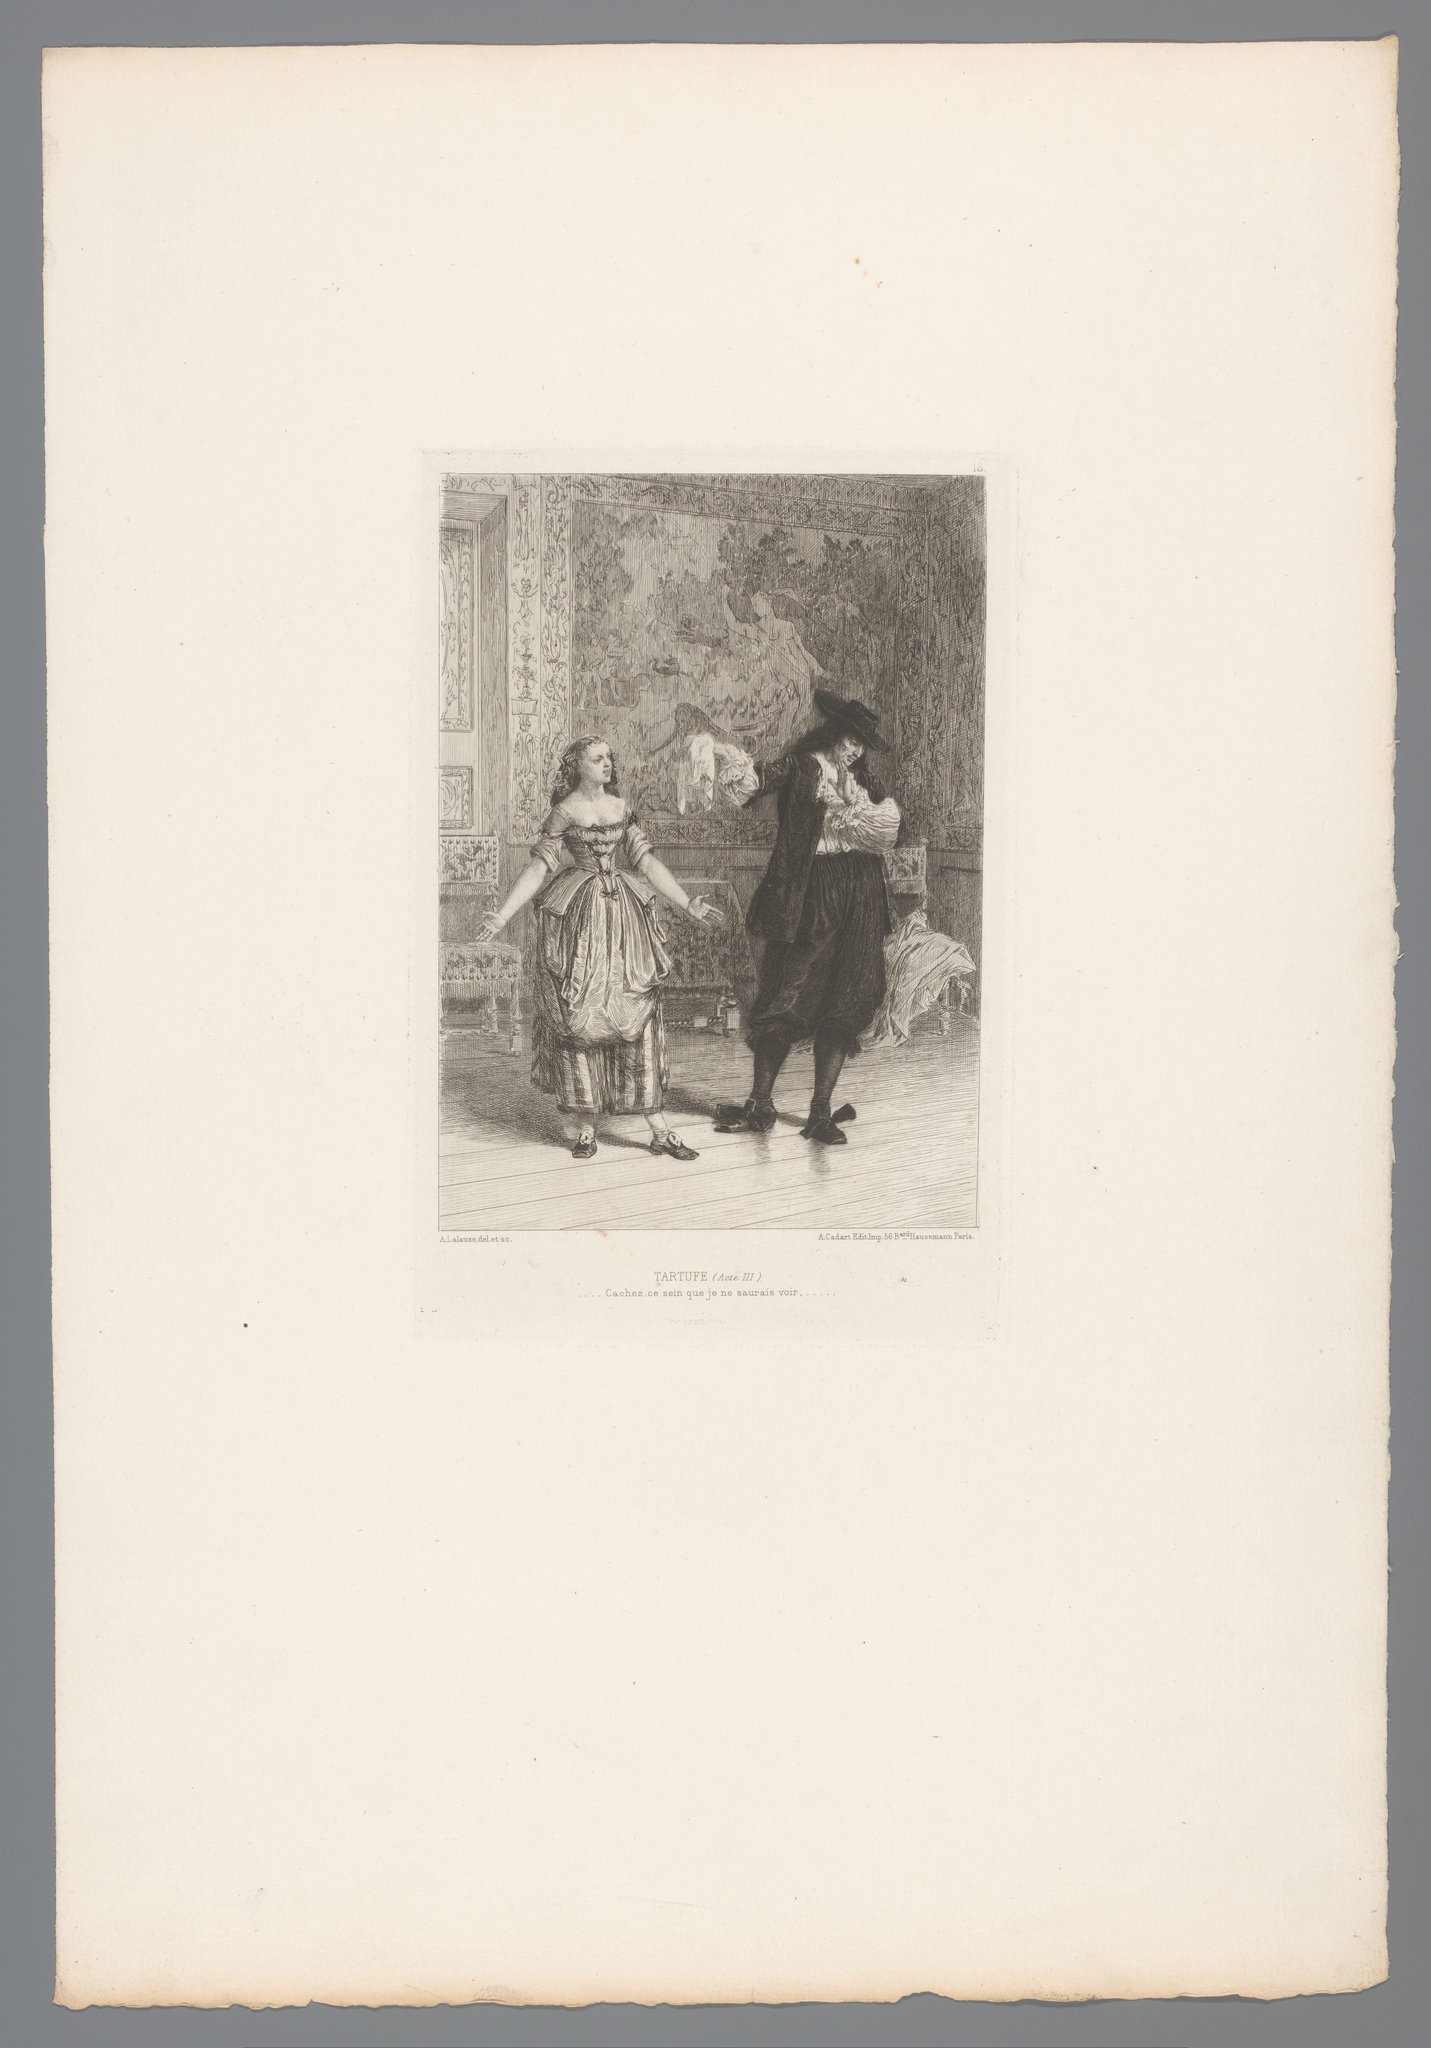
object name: print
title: L'eau-forte en 1875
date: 1875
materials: paper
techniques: drypoint, etching, intaglio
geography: paris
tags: comedy, house personnel, servants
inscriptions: collector's mark: Lugt 2228, collector's mark: ‘AFE v S’, collector's mark: Lugt 2760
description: Scène uit de komedie 'Tartuffe' van Molière.